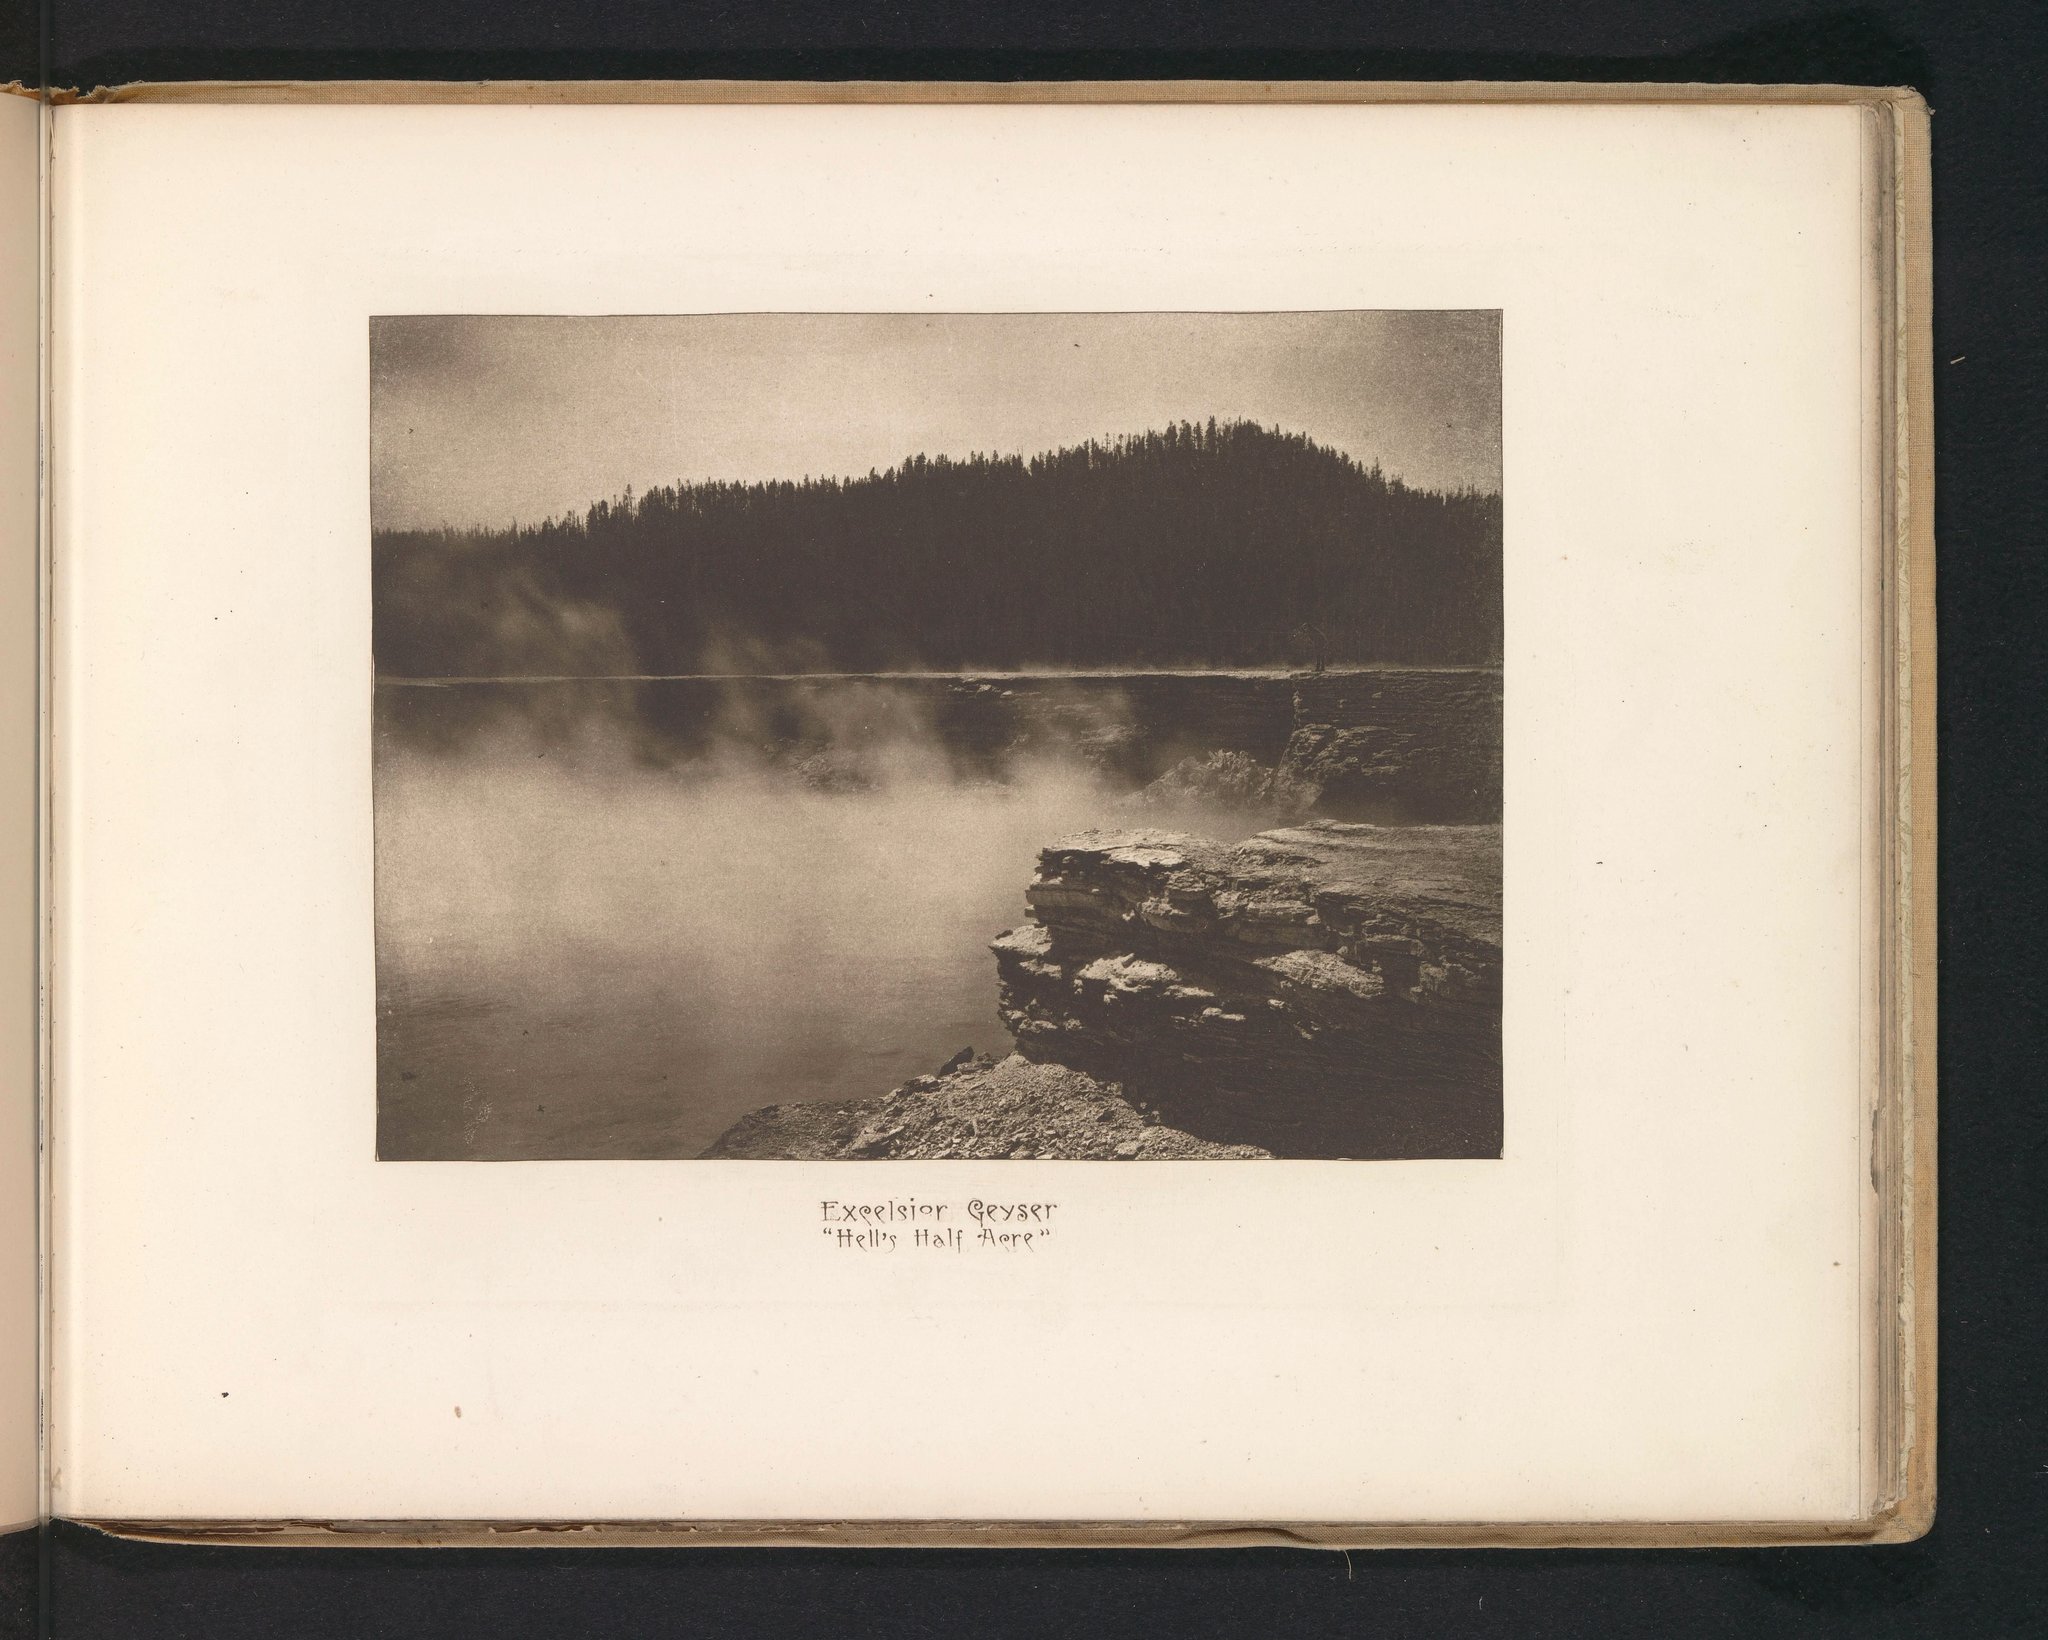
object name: photomechanical print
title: Excelsior Geyser "Hell's Half Acre"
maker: frank jay haynes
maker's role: fotograaf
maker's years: 1853-1921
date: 1882-1887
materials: paper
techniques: photoaquatint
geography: yellowstone national park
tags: hot spring, geyser